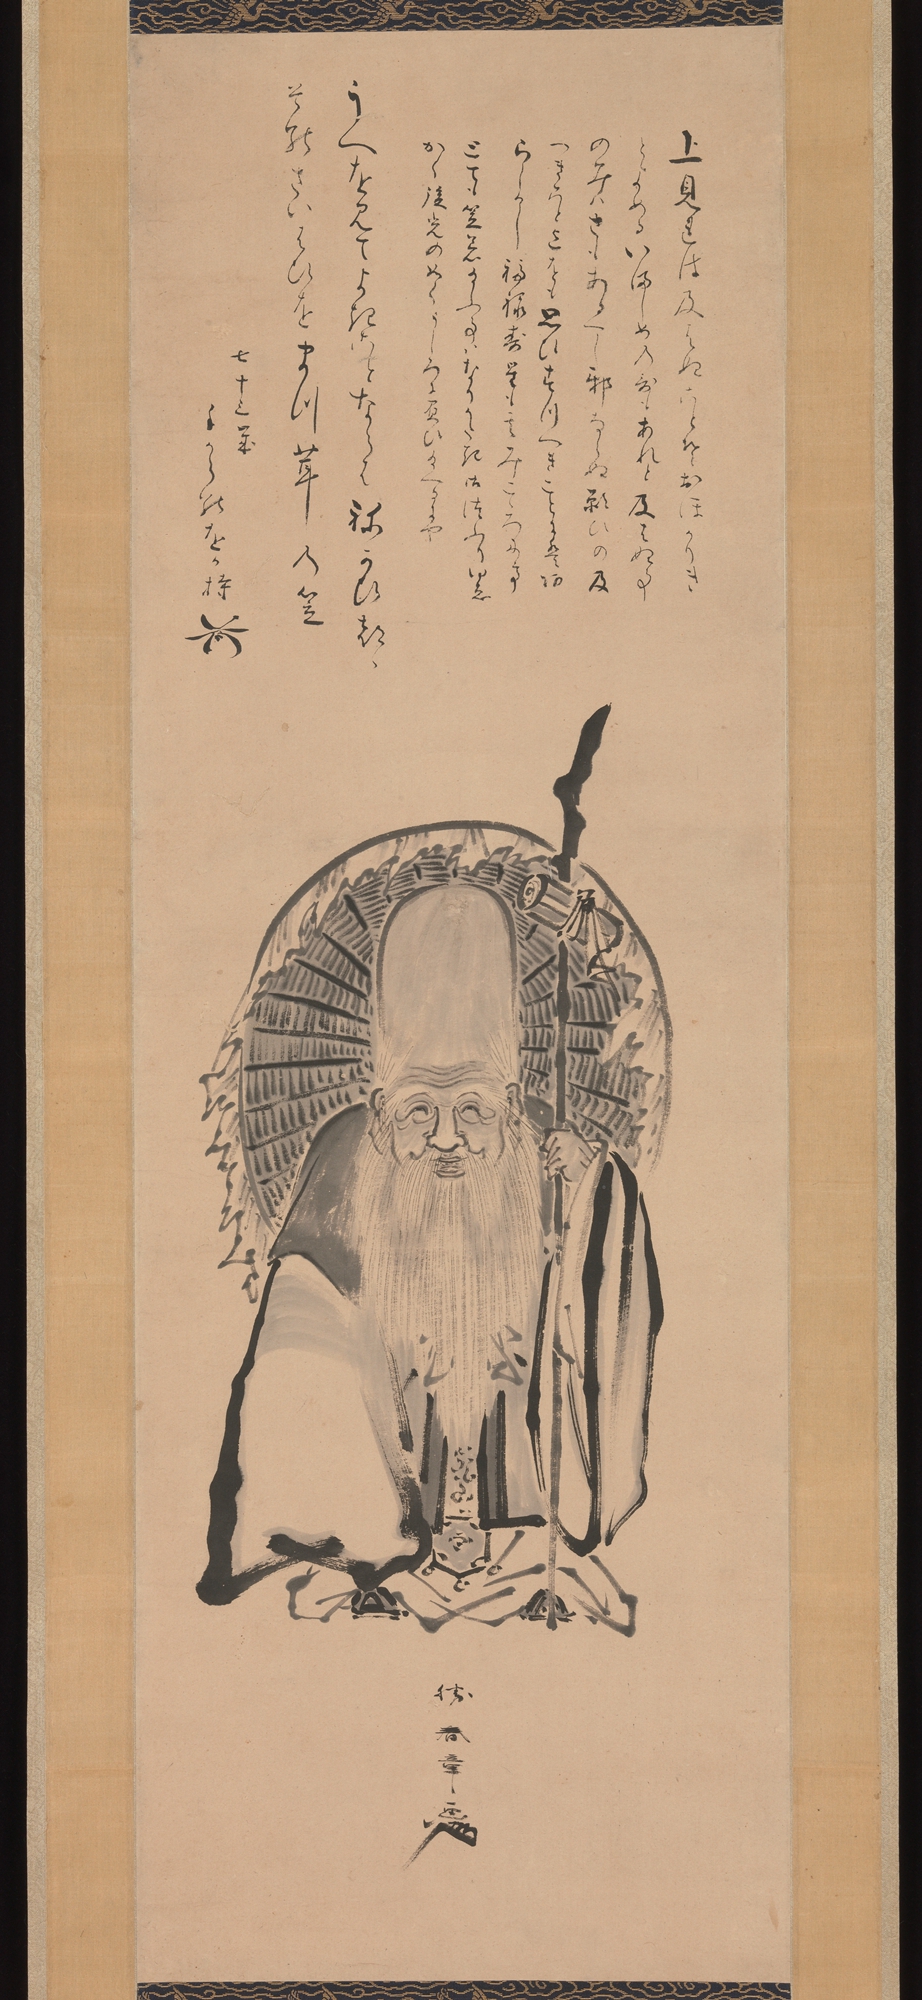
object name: hanging scroll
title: Fukurokuju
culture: japanese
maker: katsukawa shunshō 勝川春章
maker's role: artist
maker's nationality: japanese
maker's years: 1726-1792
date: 1798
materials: ink, paper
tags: men